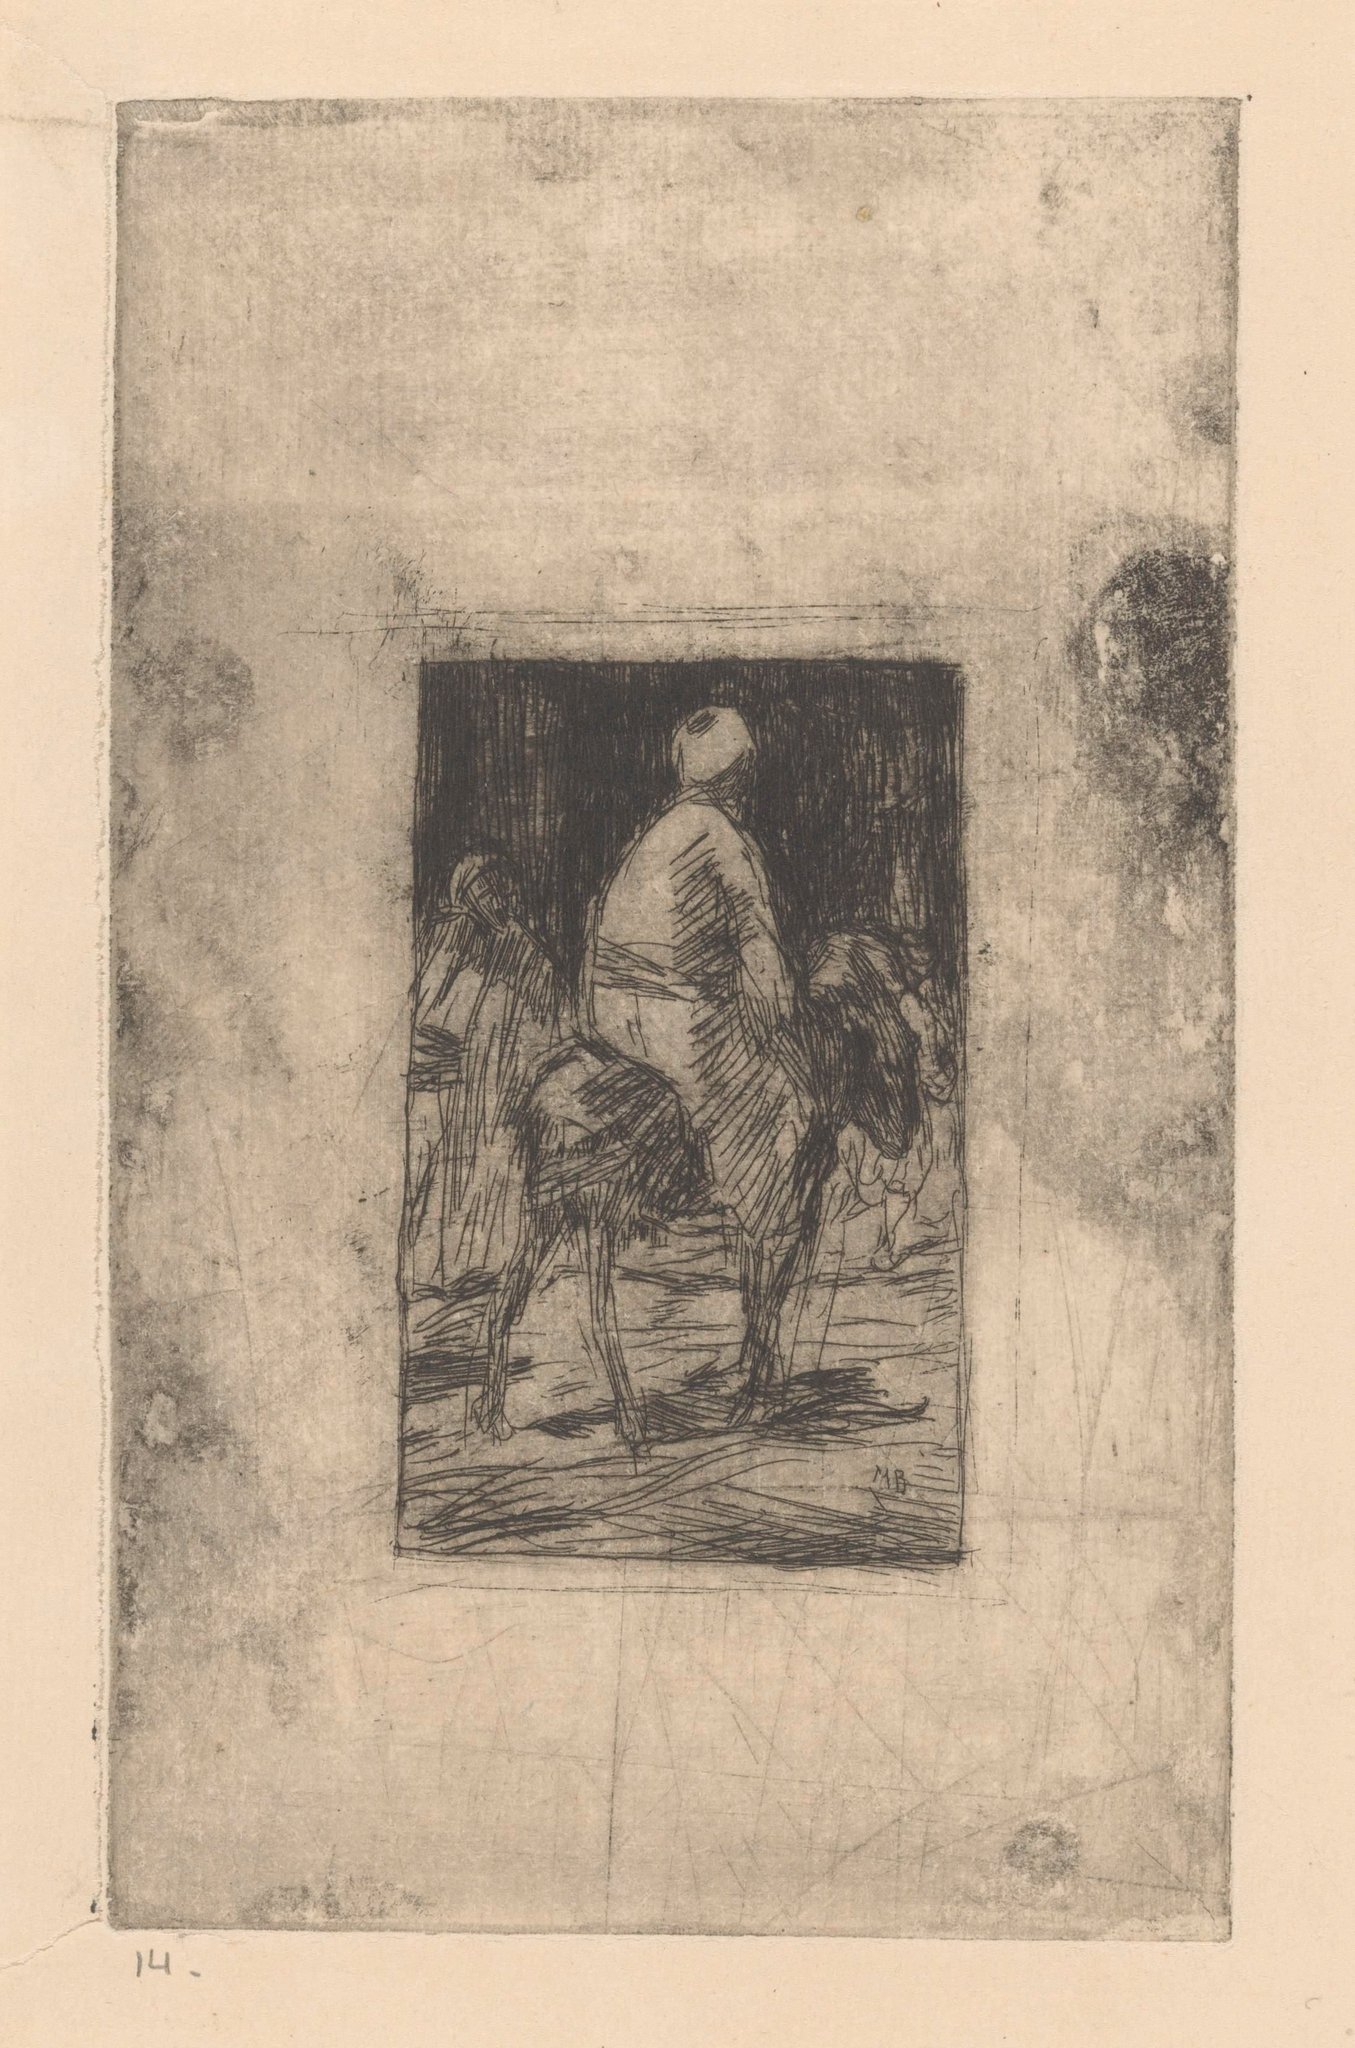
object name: print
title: Ottomaanse man op een ezel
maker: marius bauer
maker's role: draughtsman, print maker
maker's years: 1867-1932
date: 1889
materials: paper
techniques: etching, intaglio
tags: ass, donkey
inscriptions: collector's mark: Lugt 2228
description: Een man in oosterse kleding rijdend op een ezel.